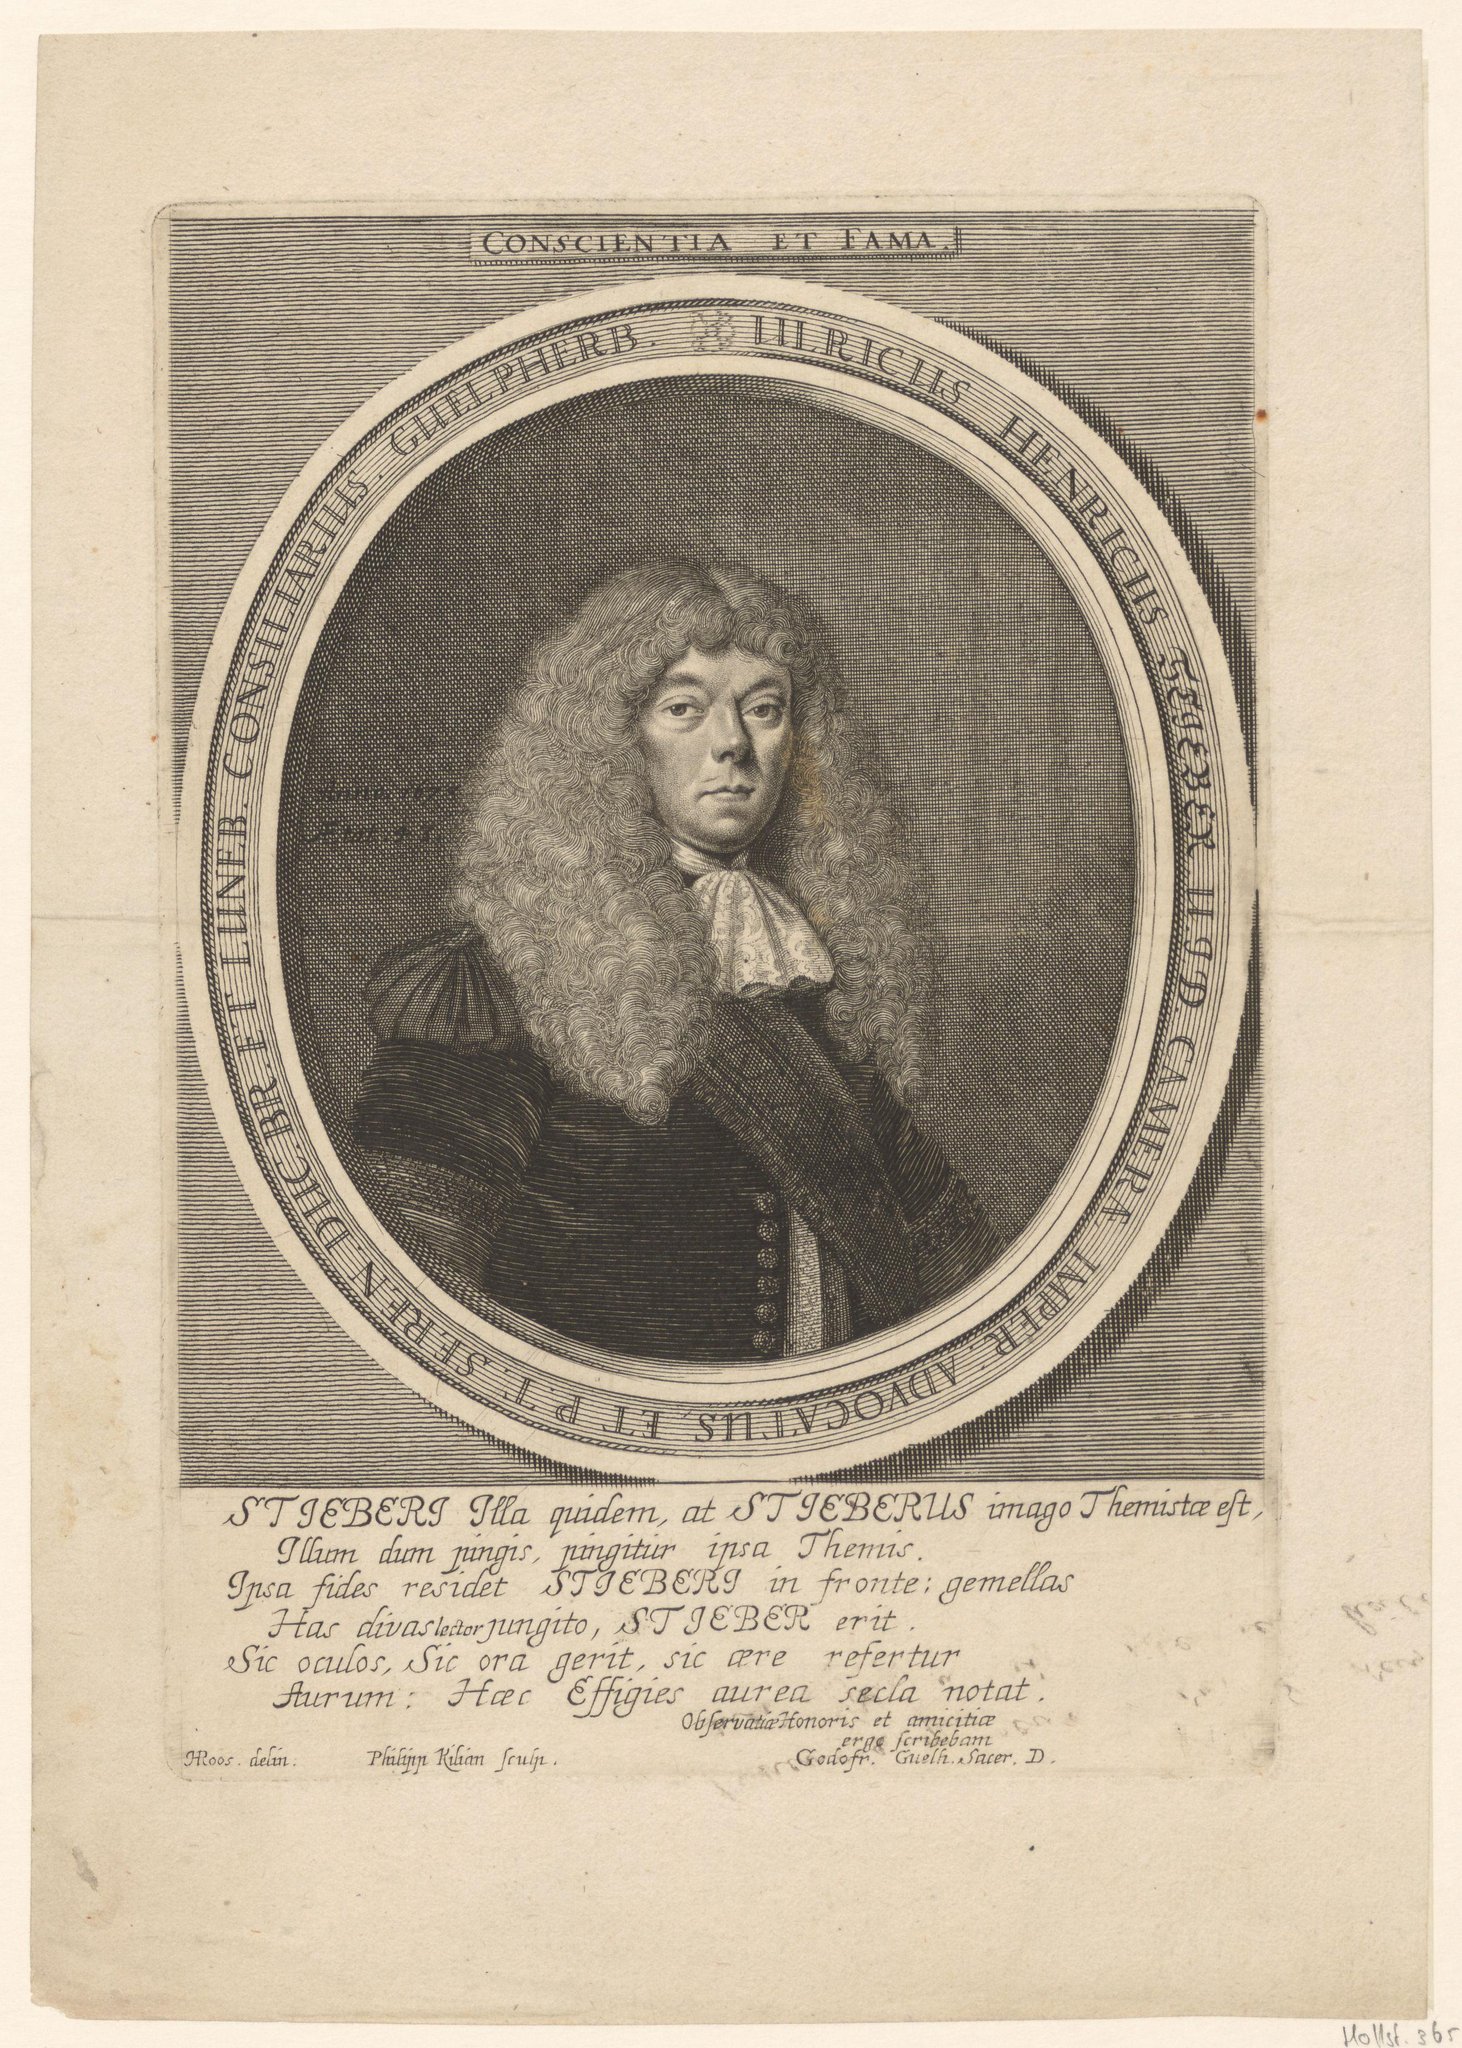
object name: print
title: Portret van Ulrich Heinrich Stieber op 43-jarige leeftijd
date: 1673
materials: paper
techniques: engraving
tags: historical persons, lawyer, attorney at law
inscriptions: collector's mark: Lugt 2228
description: Tekst in het Latijn in de omlijsting en in de ondermarge.